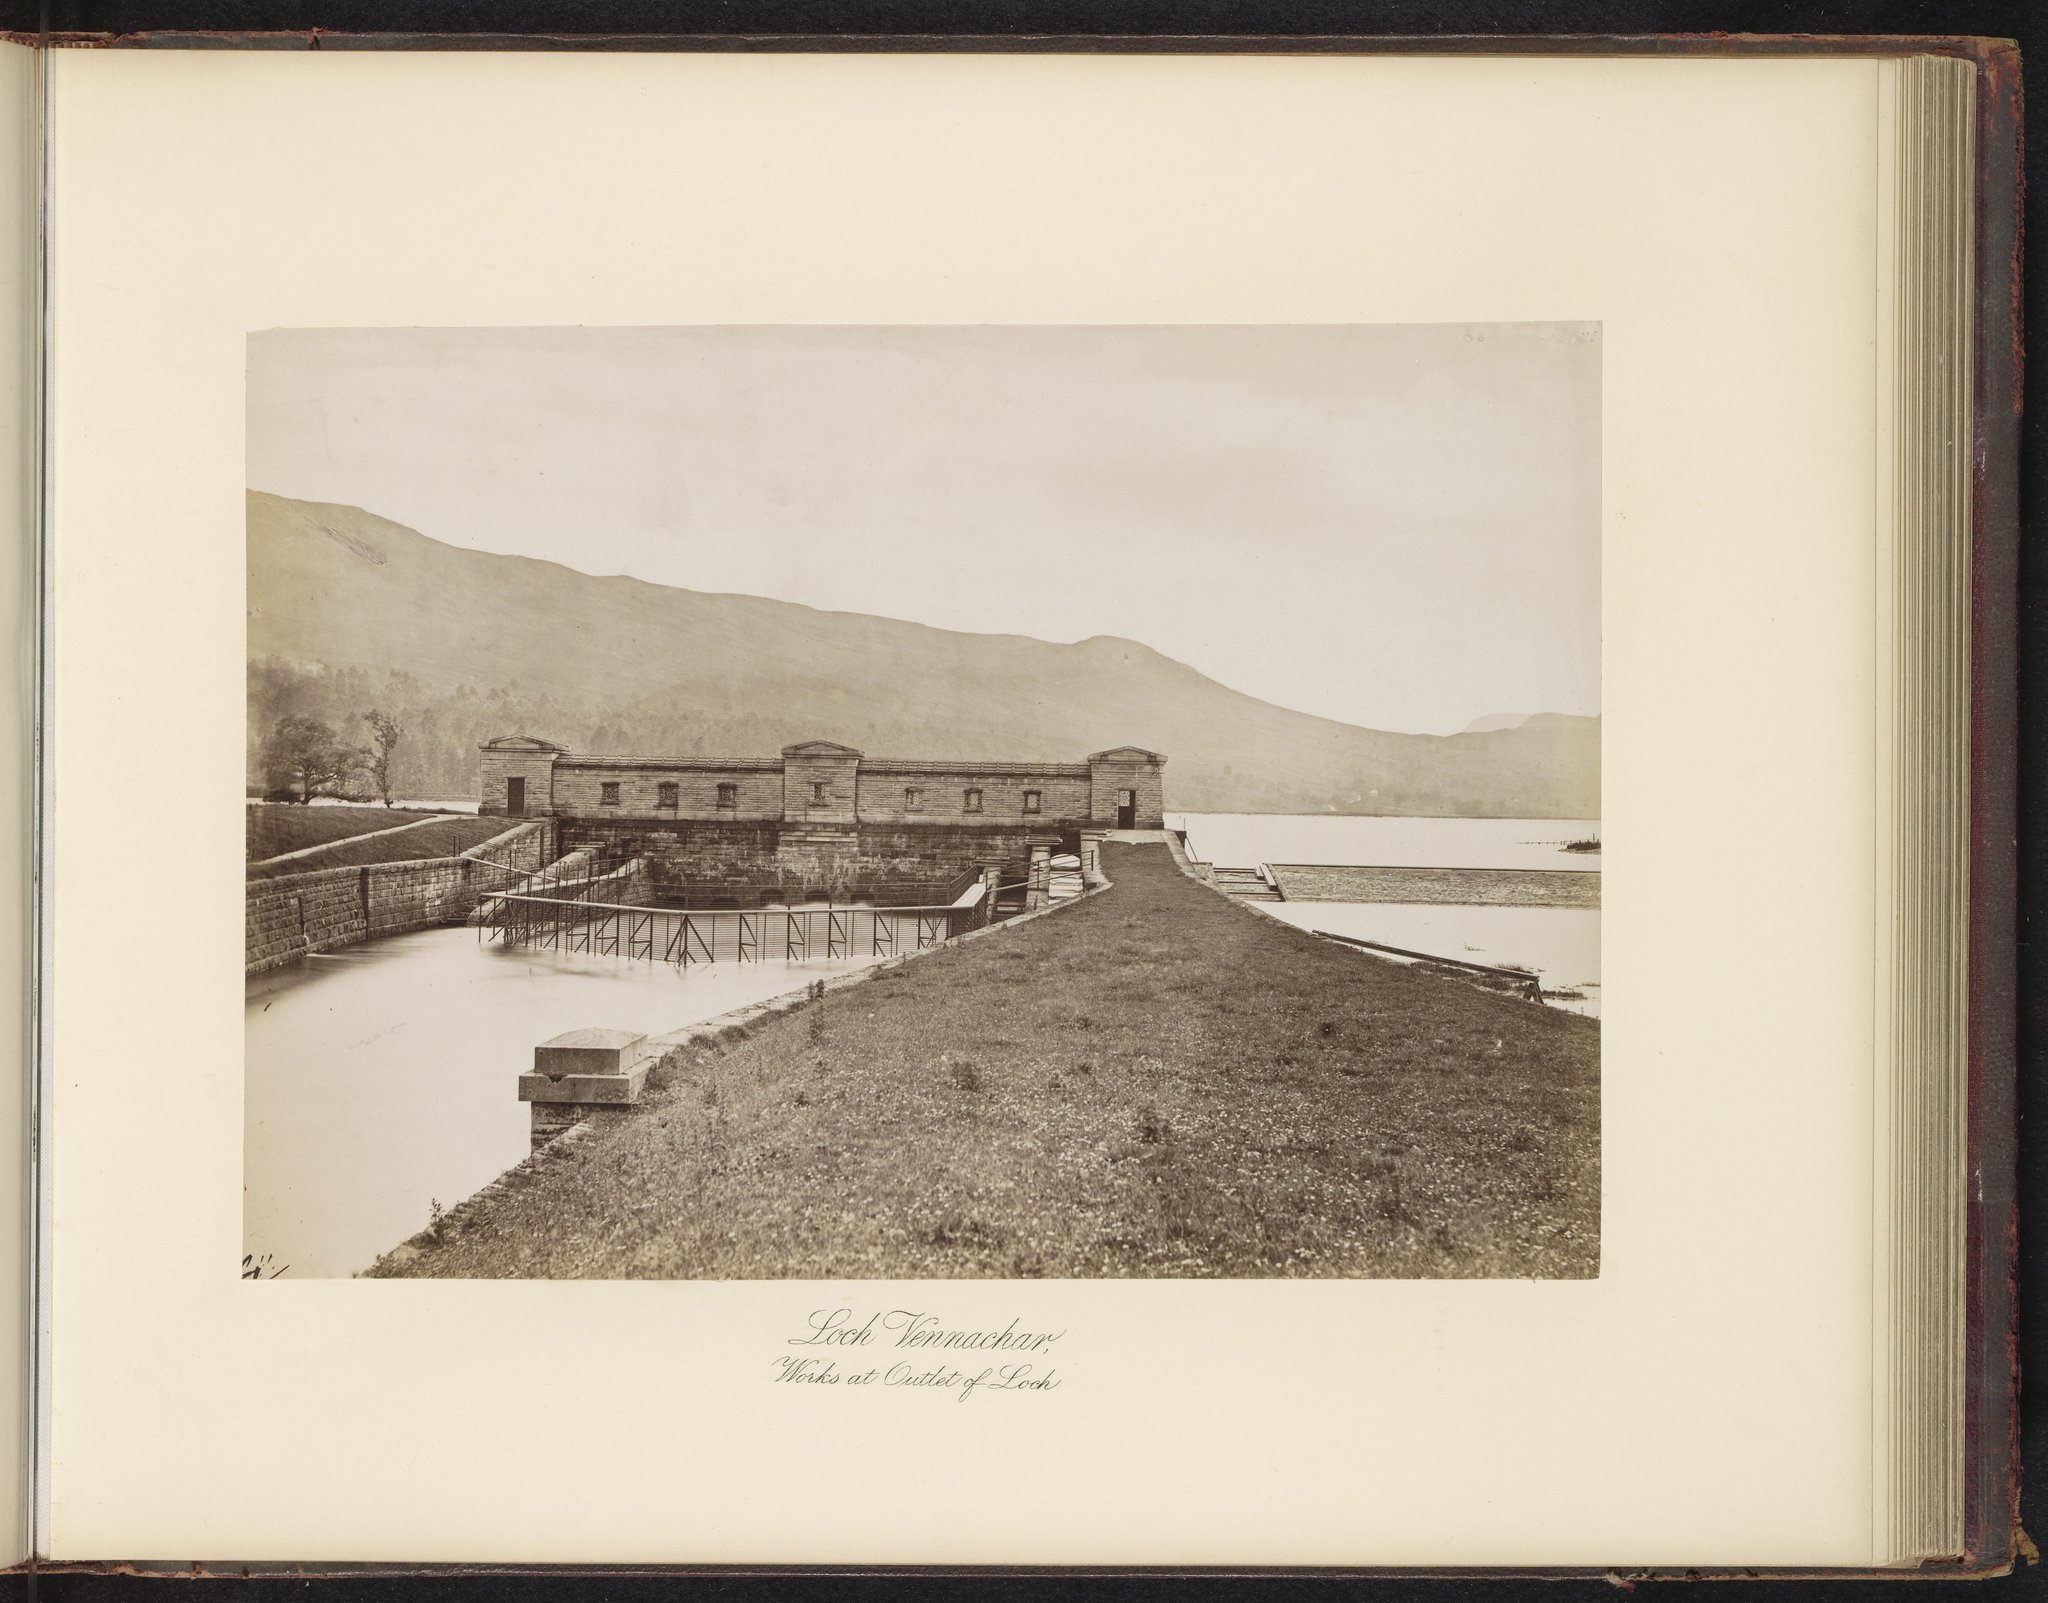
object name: page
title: Loch Vennachar, works at outlet of loch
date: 1879-1889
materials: photographic support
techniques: albumen print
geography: stirling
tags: sluice, weir, low hill country, lake, façade (of house or building)